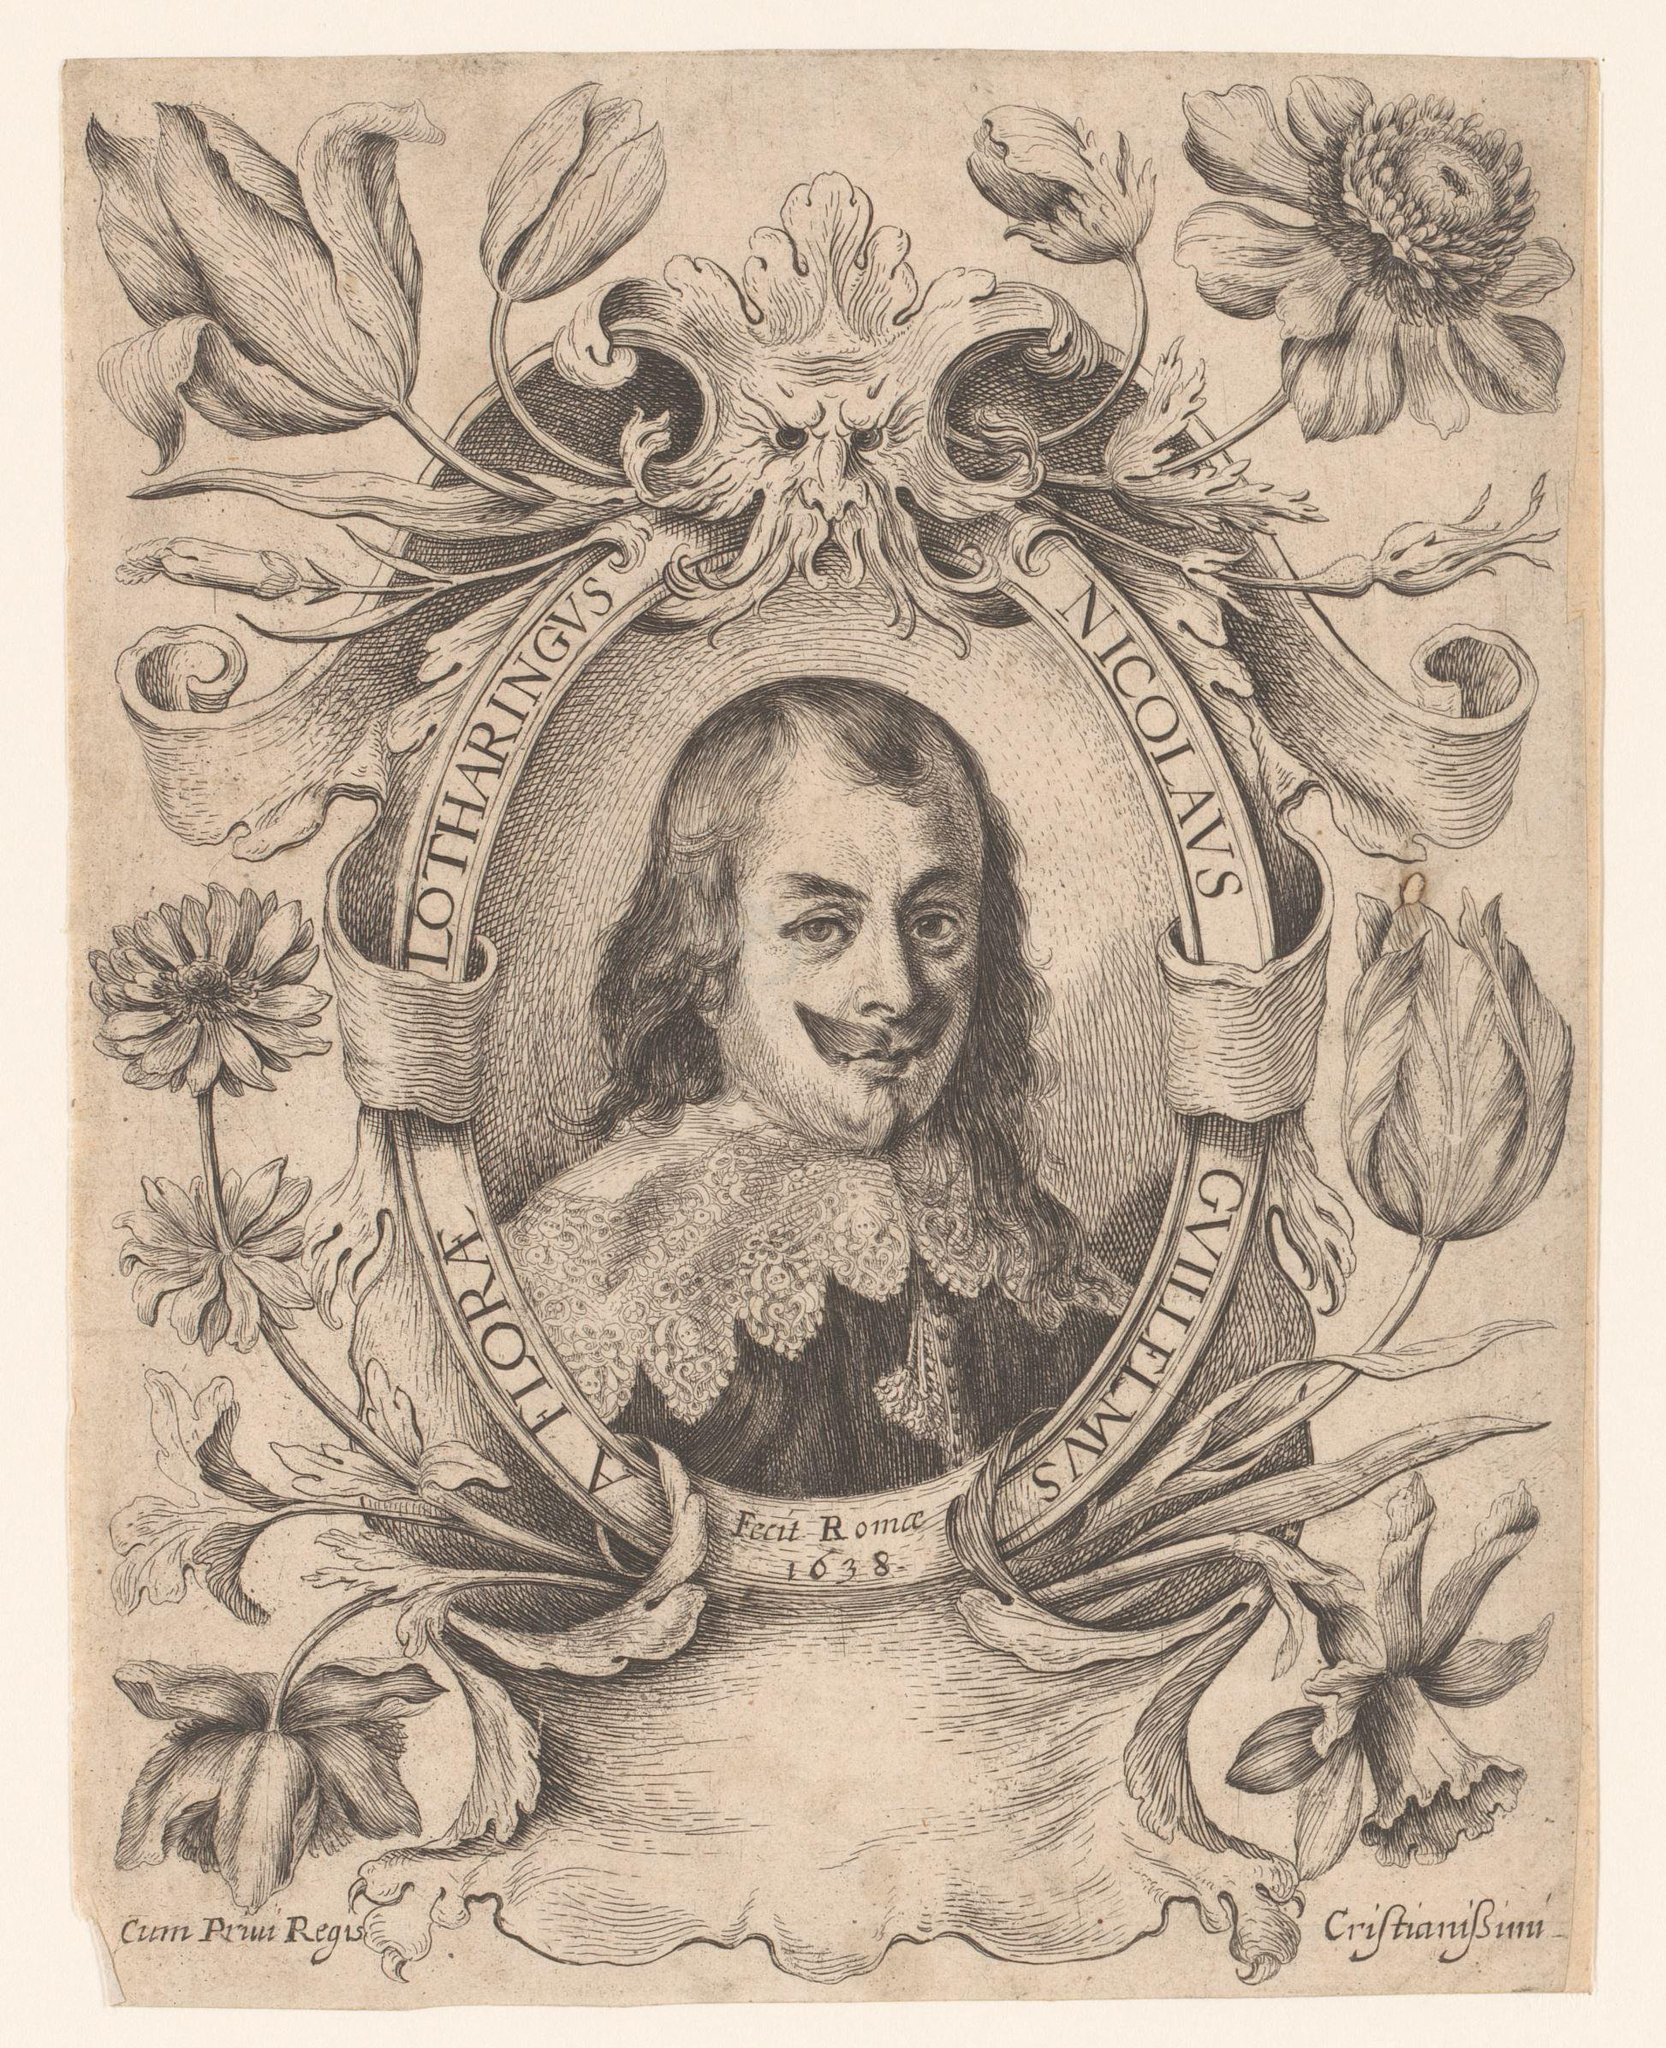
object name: print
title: Zelfportret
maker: nicolas guillaume de la fleur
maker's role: print maker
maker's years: -1663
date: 1638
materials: paper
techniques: engraving, etching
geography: rome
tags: nicolas guillaume de la fleur, flowers, historical persons, portrait, self-portrait of graphic artist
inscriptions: collector's mark: Lugt 2228